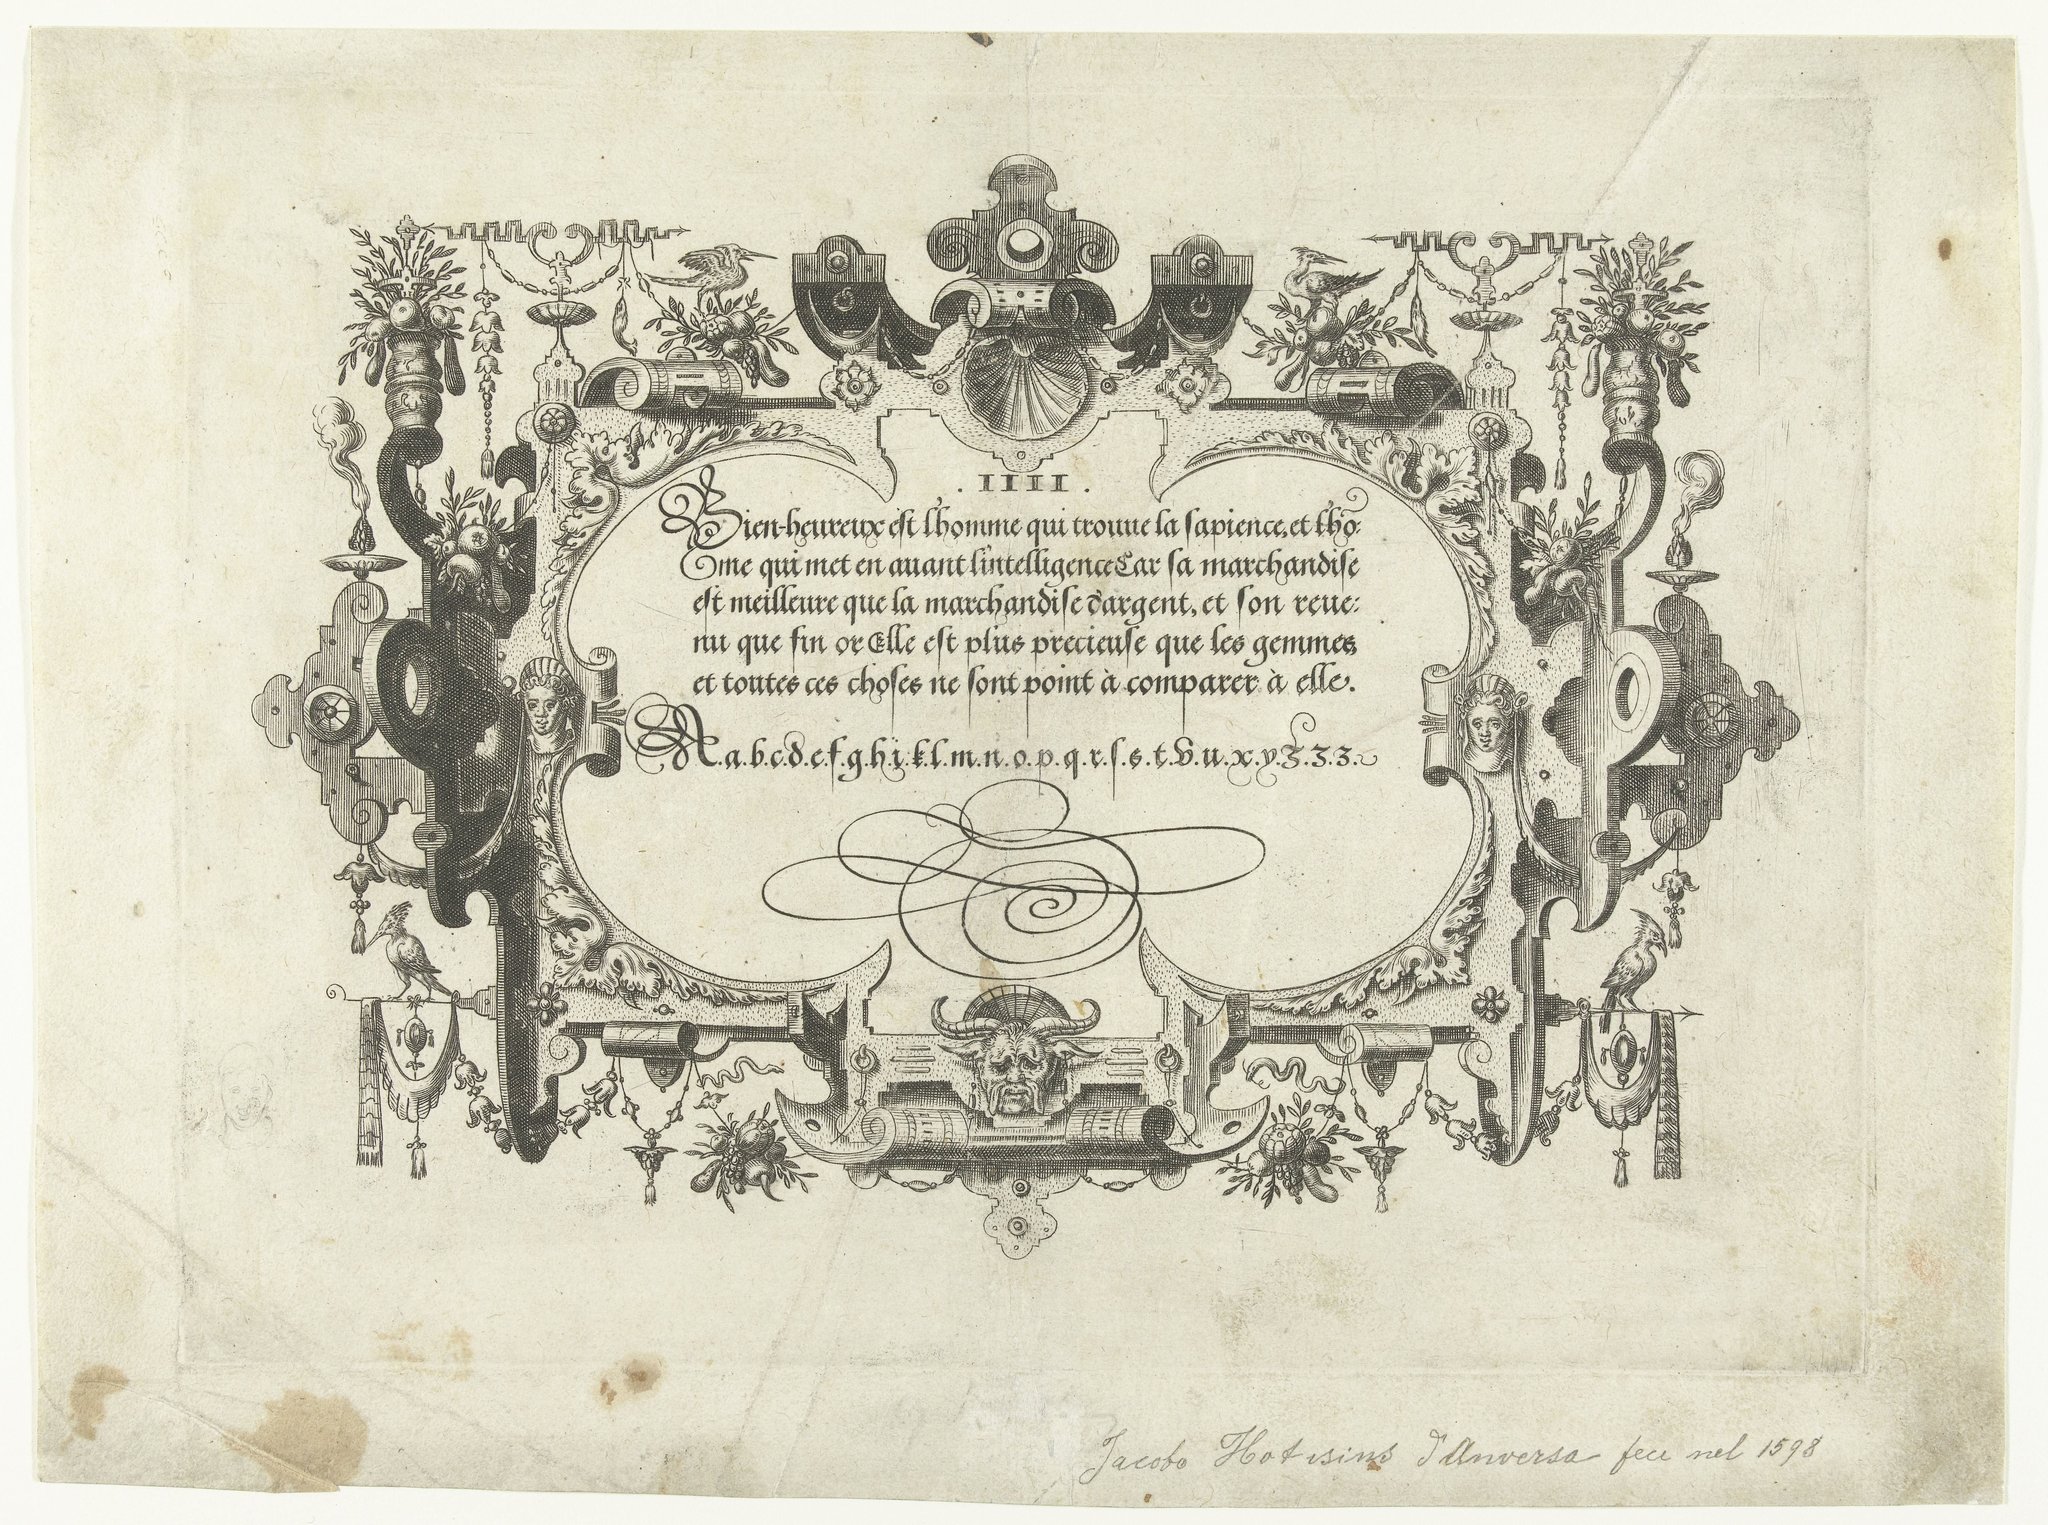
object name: ornament print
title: Cartouche met kalligrafie, waarvan de hoeken met een bladmotief zijn gedecoreerd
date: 1569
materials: paper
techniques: engraving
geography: netherlands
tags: ornament ~ cartouche, calligraphy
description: Blad IIII. Cartouche met de tekst Bien-heureux est l’homme…. Boven cartouche een schelp. Middenonder een mascaron met horens. Uit serie van 21 genummerde cartouches met kalligrafie in een omlijsting van rol- en beslagwerk met grotesken, guirlandes en mascarons.